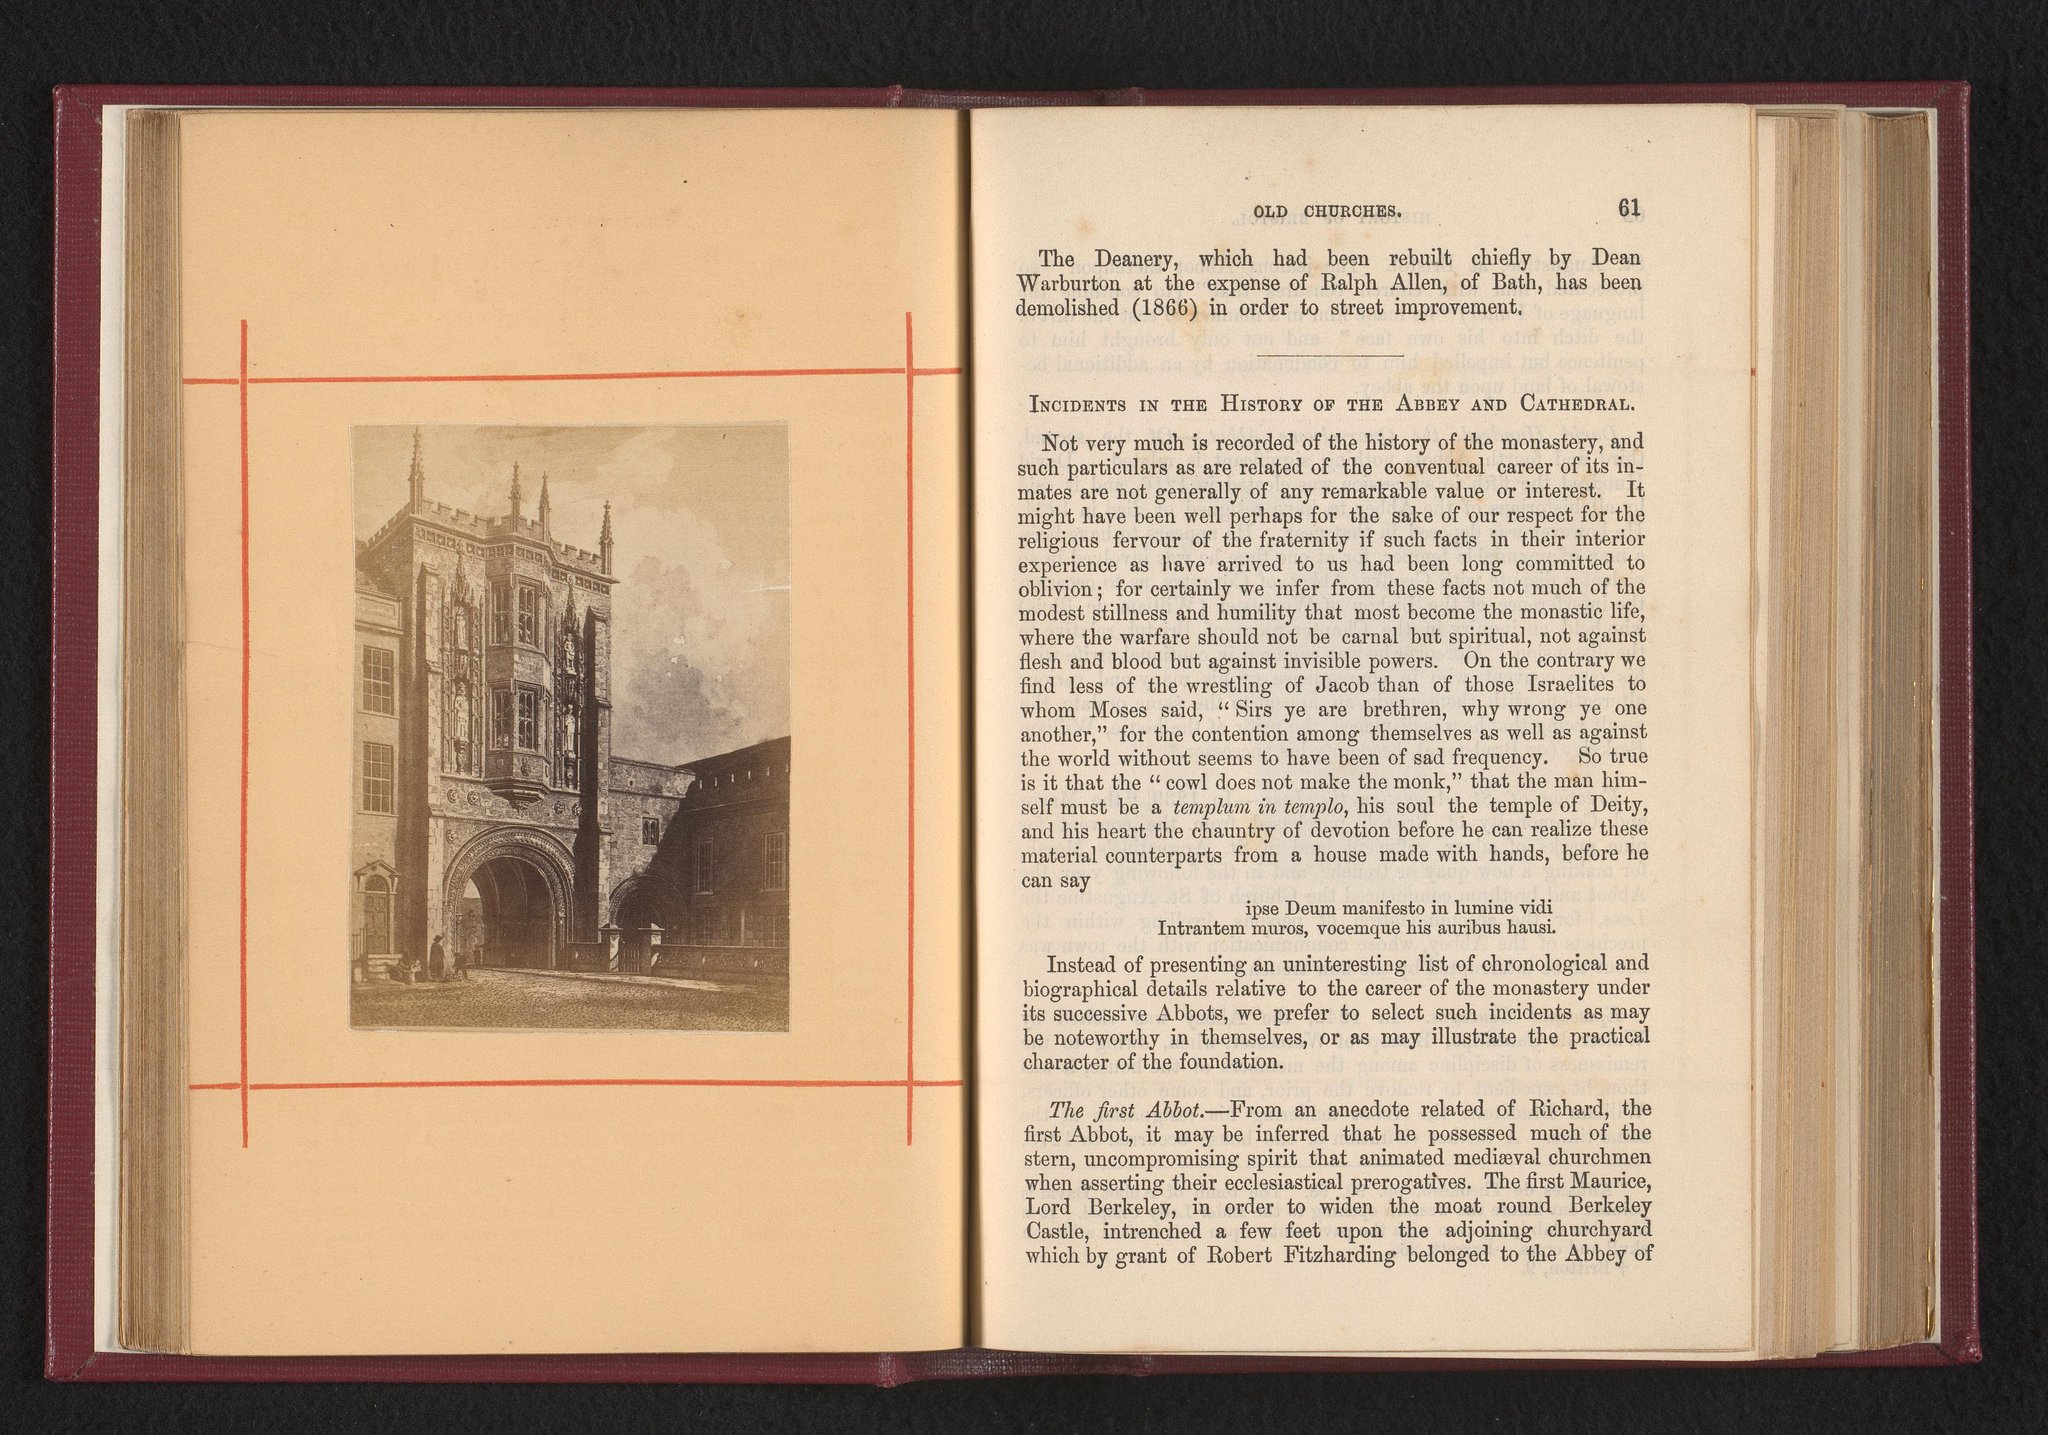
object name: page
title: Gezicht op St. Augustine's Gate te Bristol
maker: Anonymous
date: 1867-1872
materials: photographic support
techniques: albumen print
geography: bristol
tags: gate, entrance